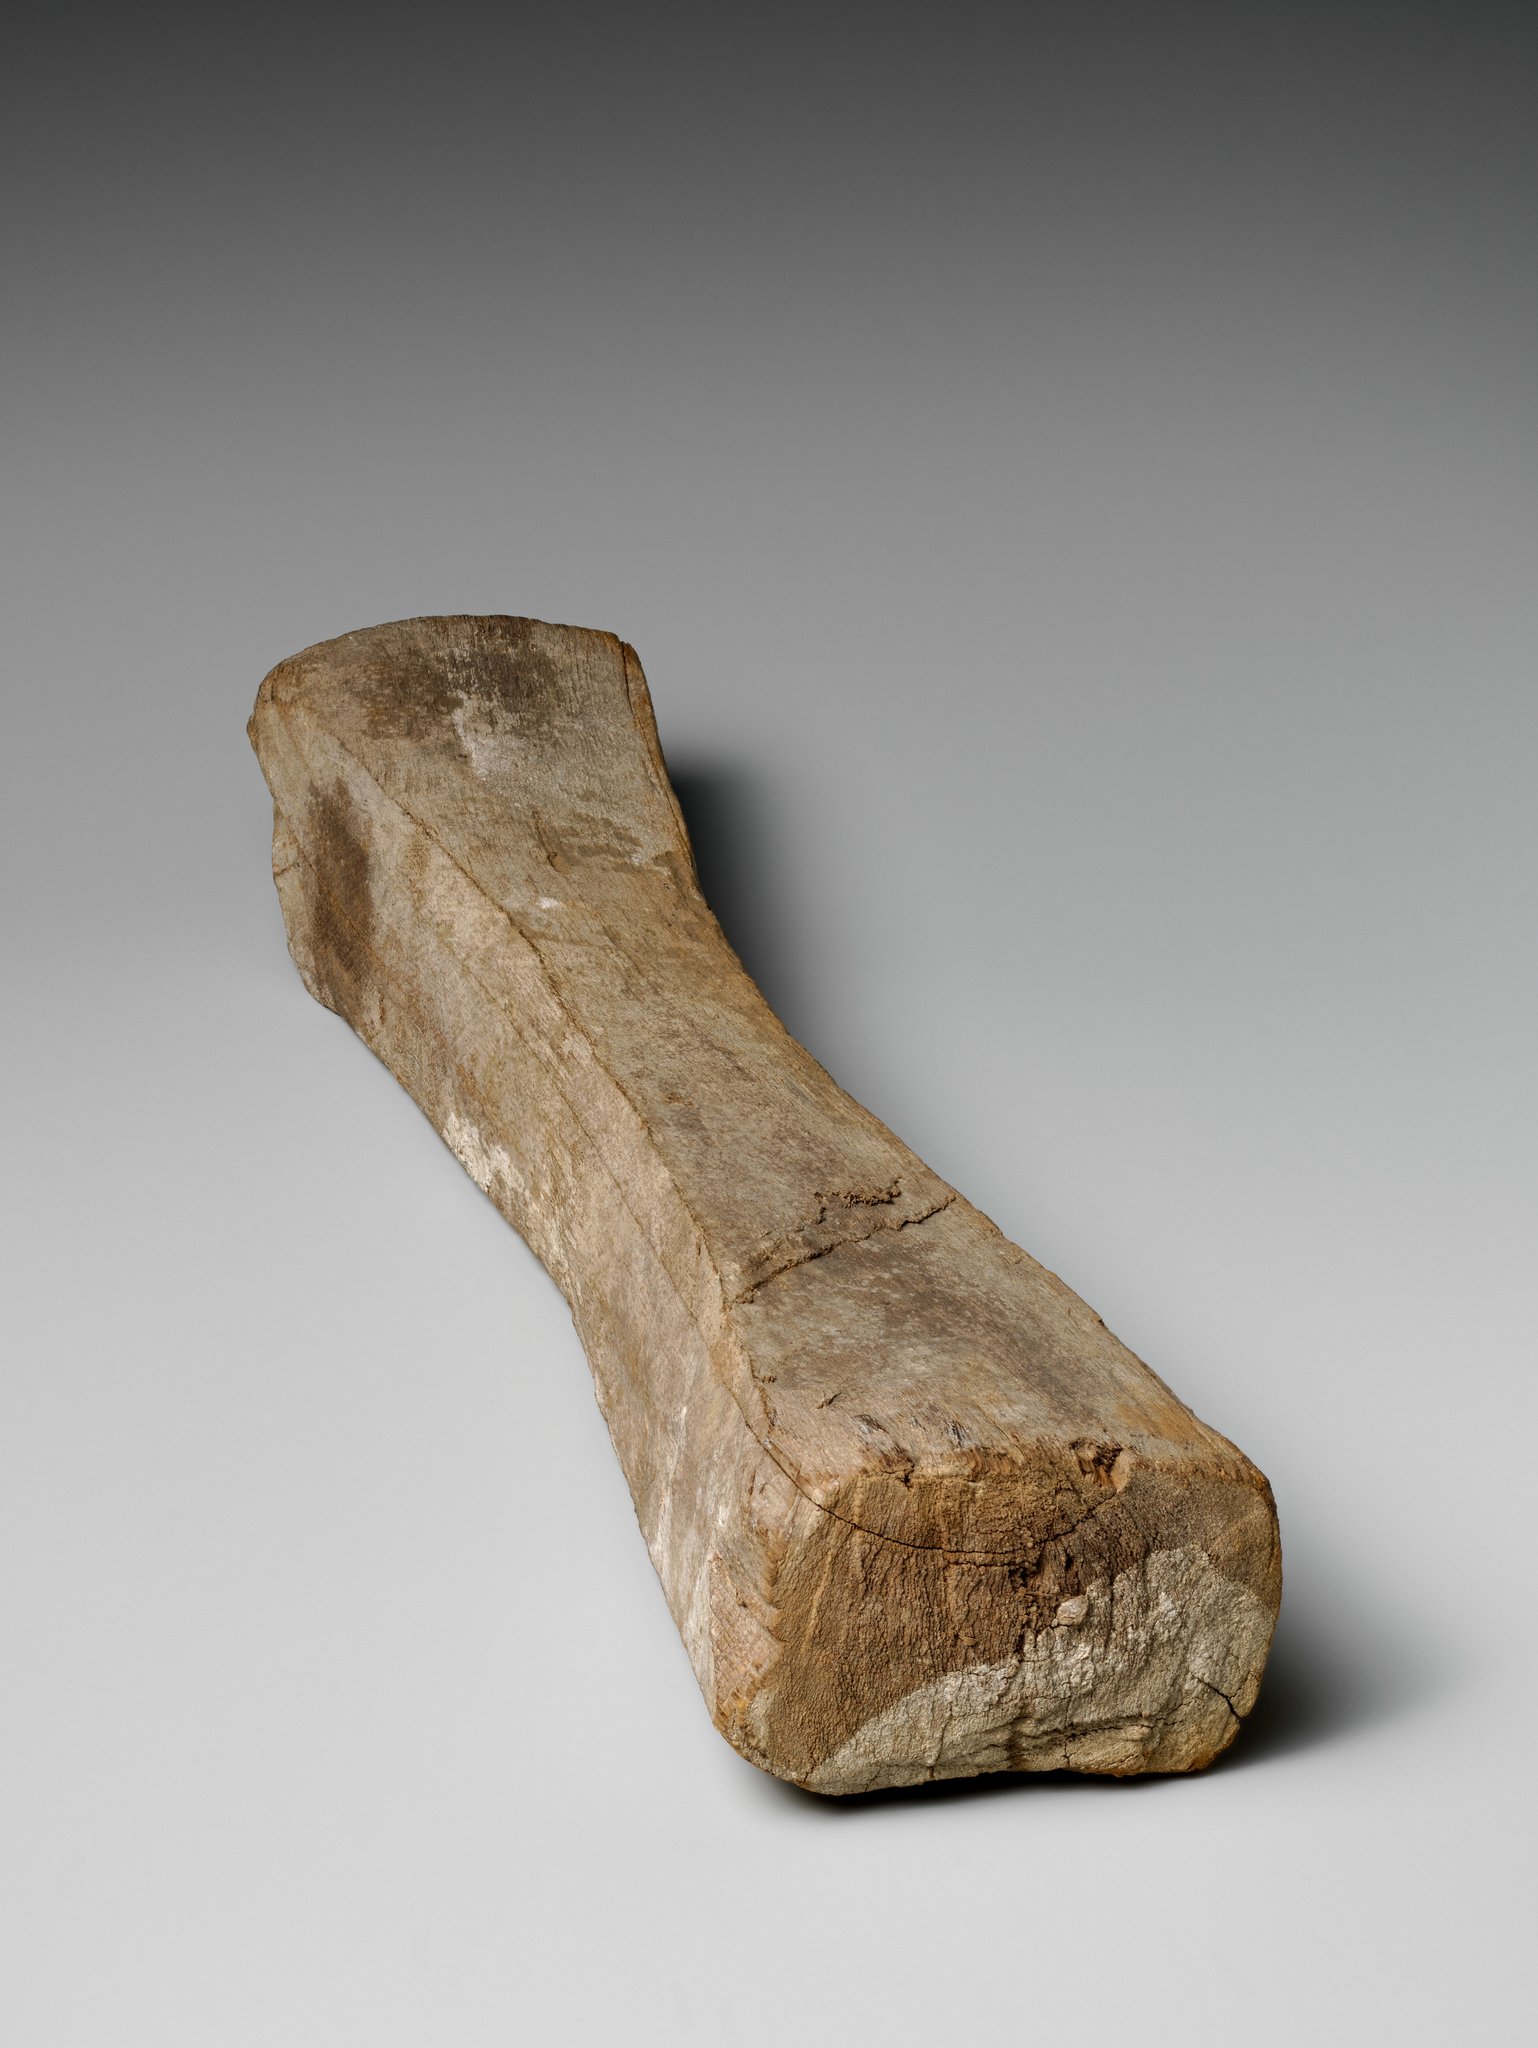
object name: builder's cramp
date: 1981-1952 BCE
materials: wood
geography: egypt